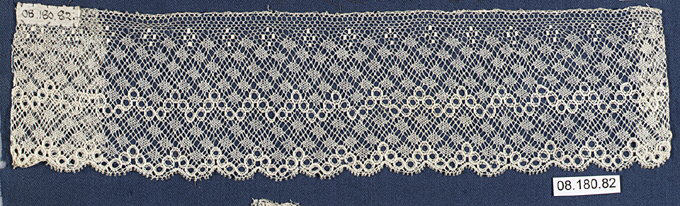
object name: fragment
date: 1801-1900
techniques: lace